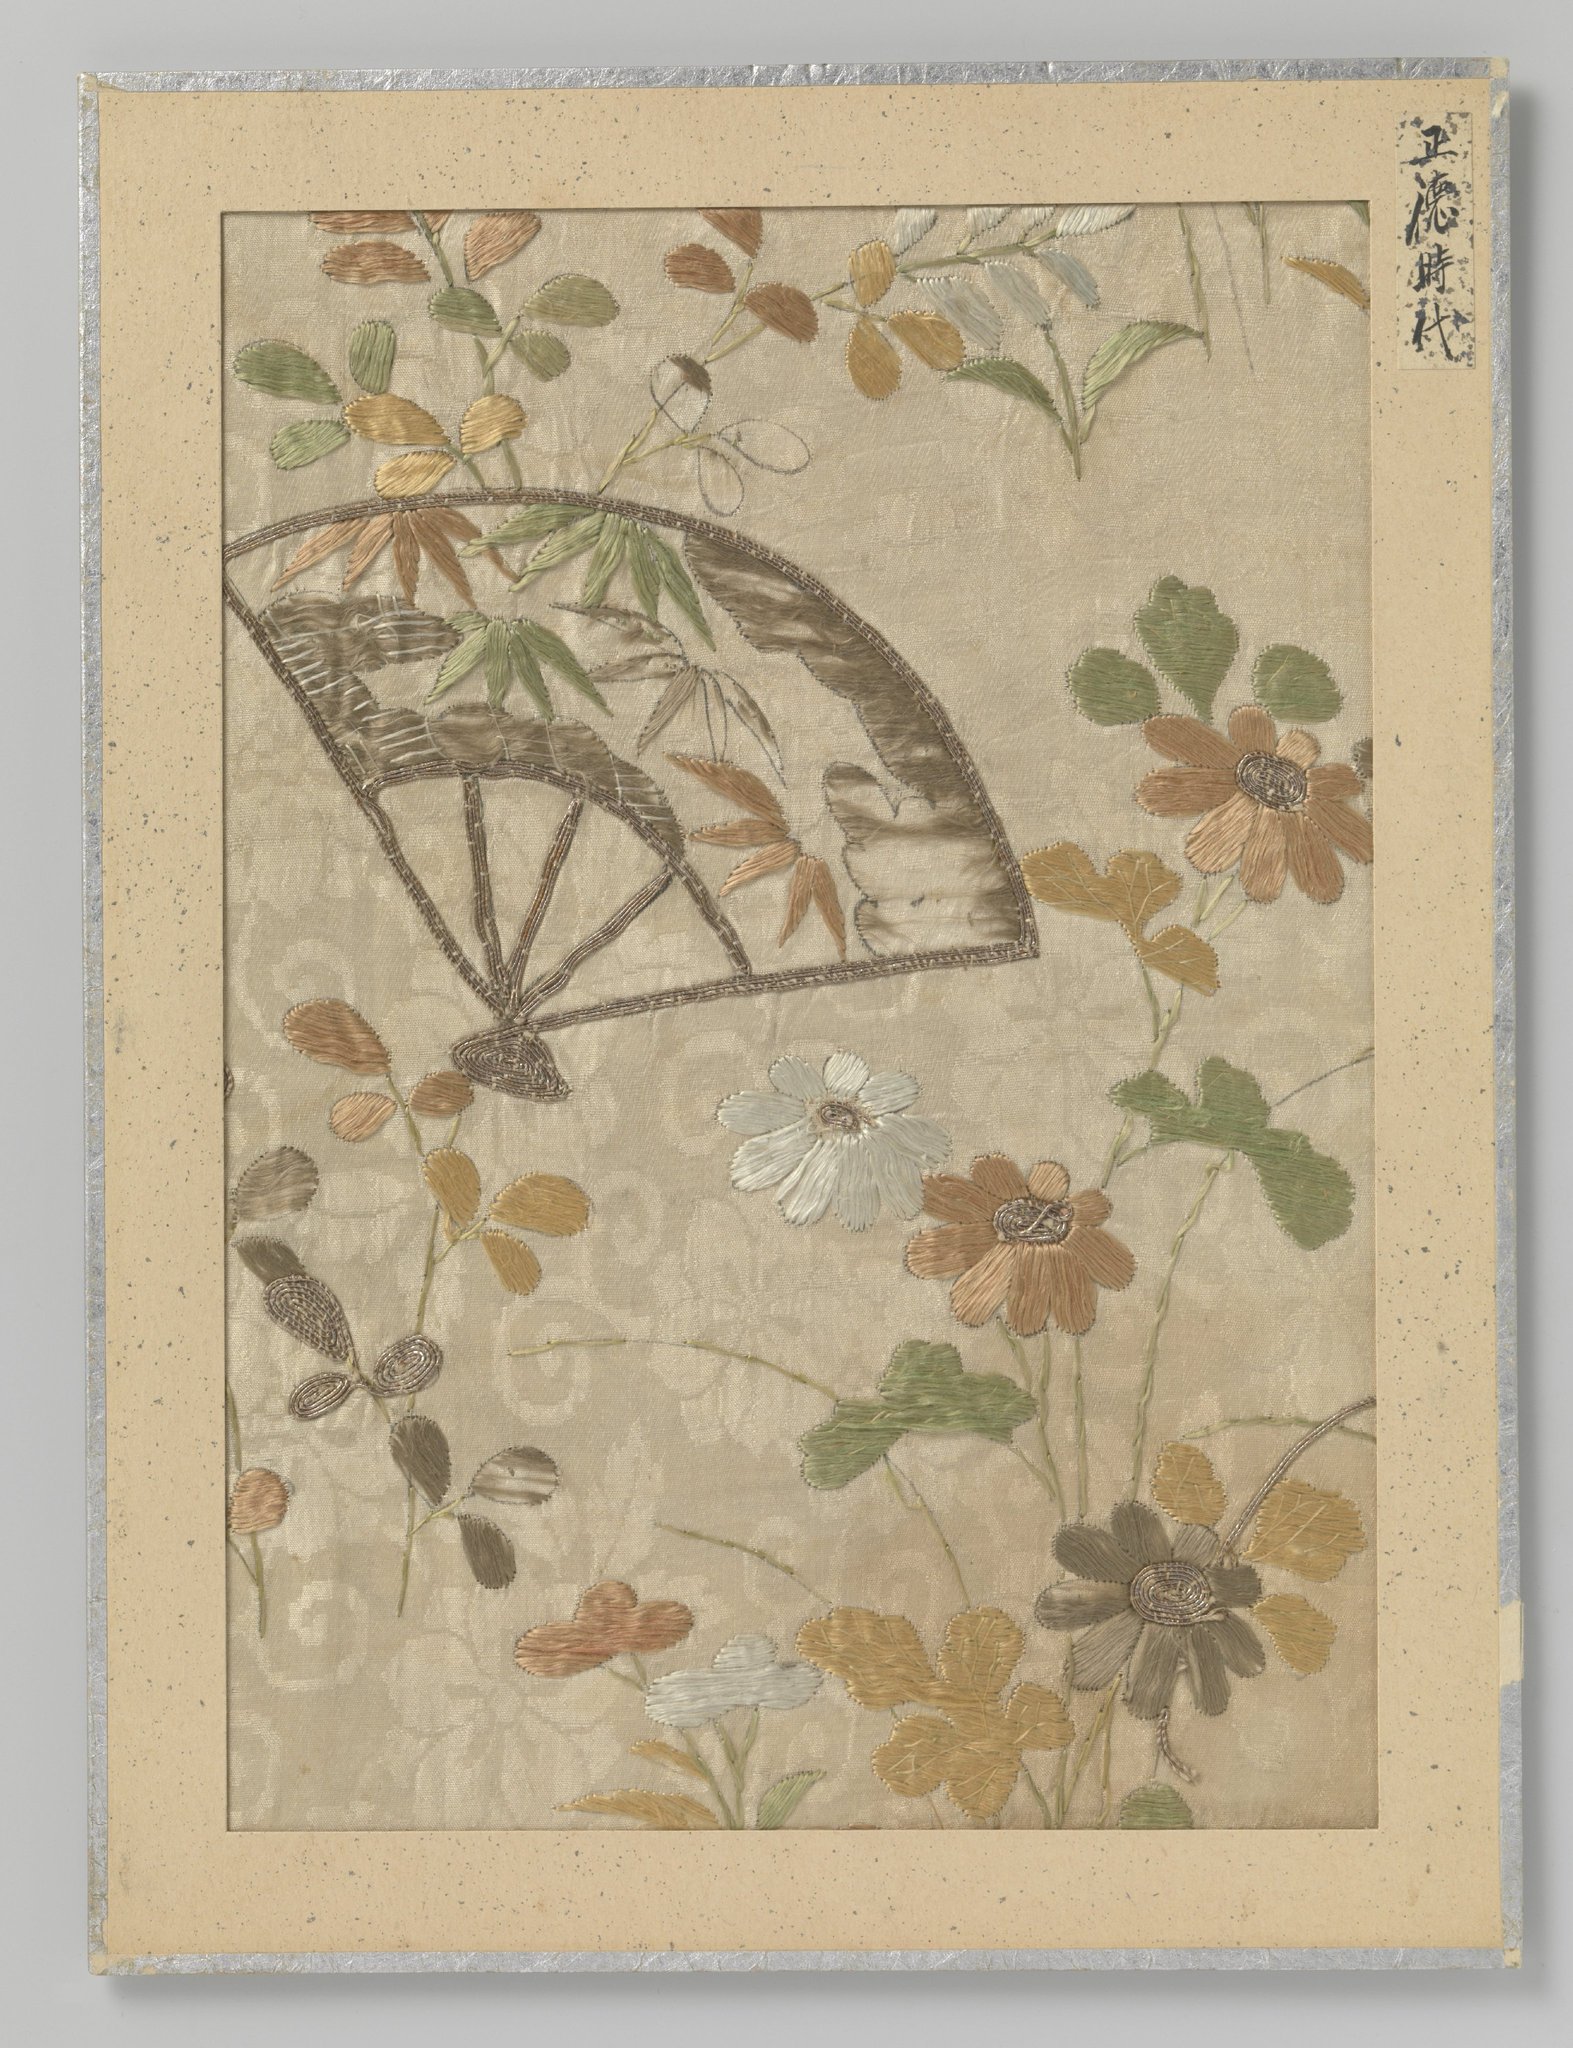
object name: fragment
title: Textielfragment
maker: Anonymous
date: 1711-1716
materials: silk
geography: japan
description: Textielfragment, borduursel van bloemen en een waaier op beige damast.